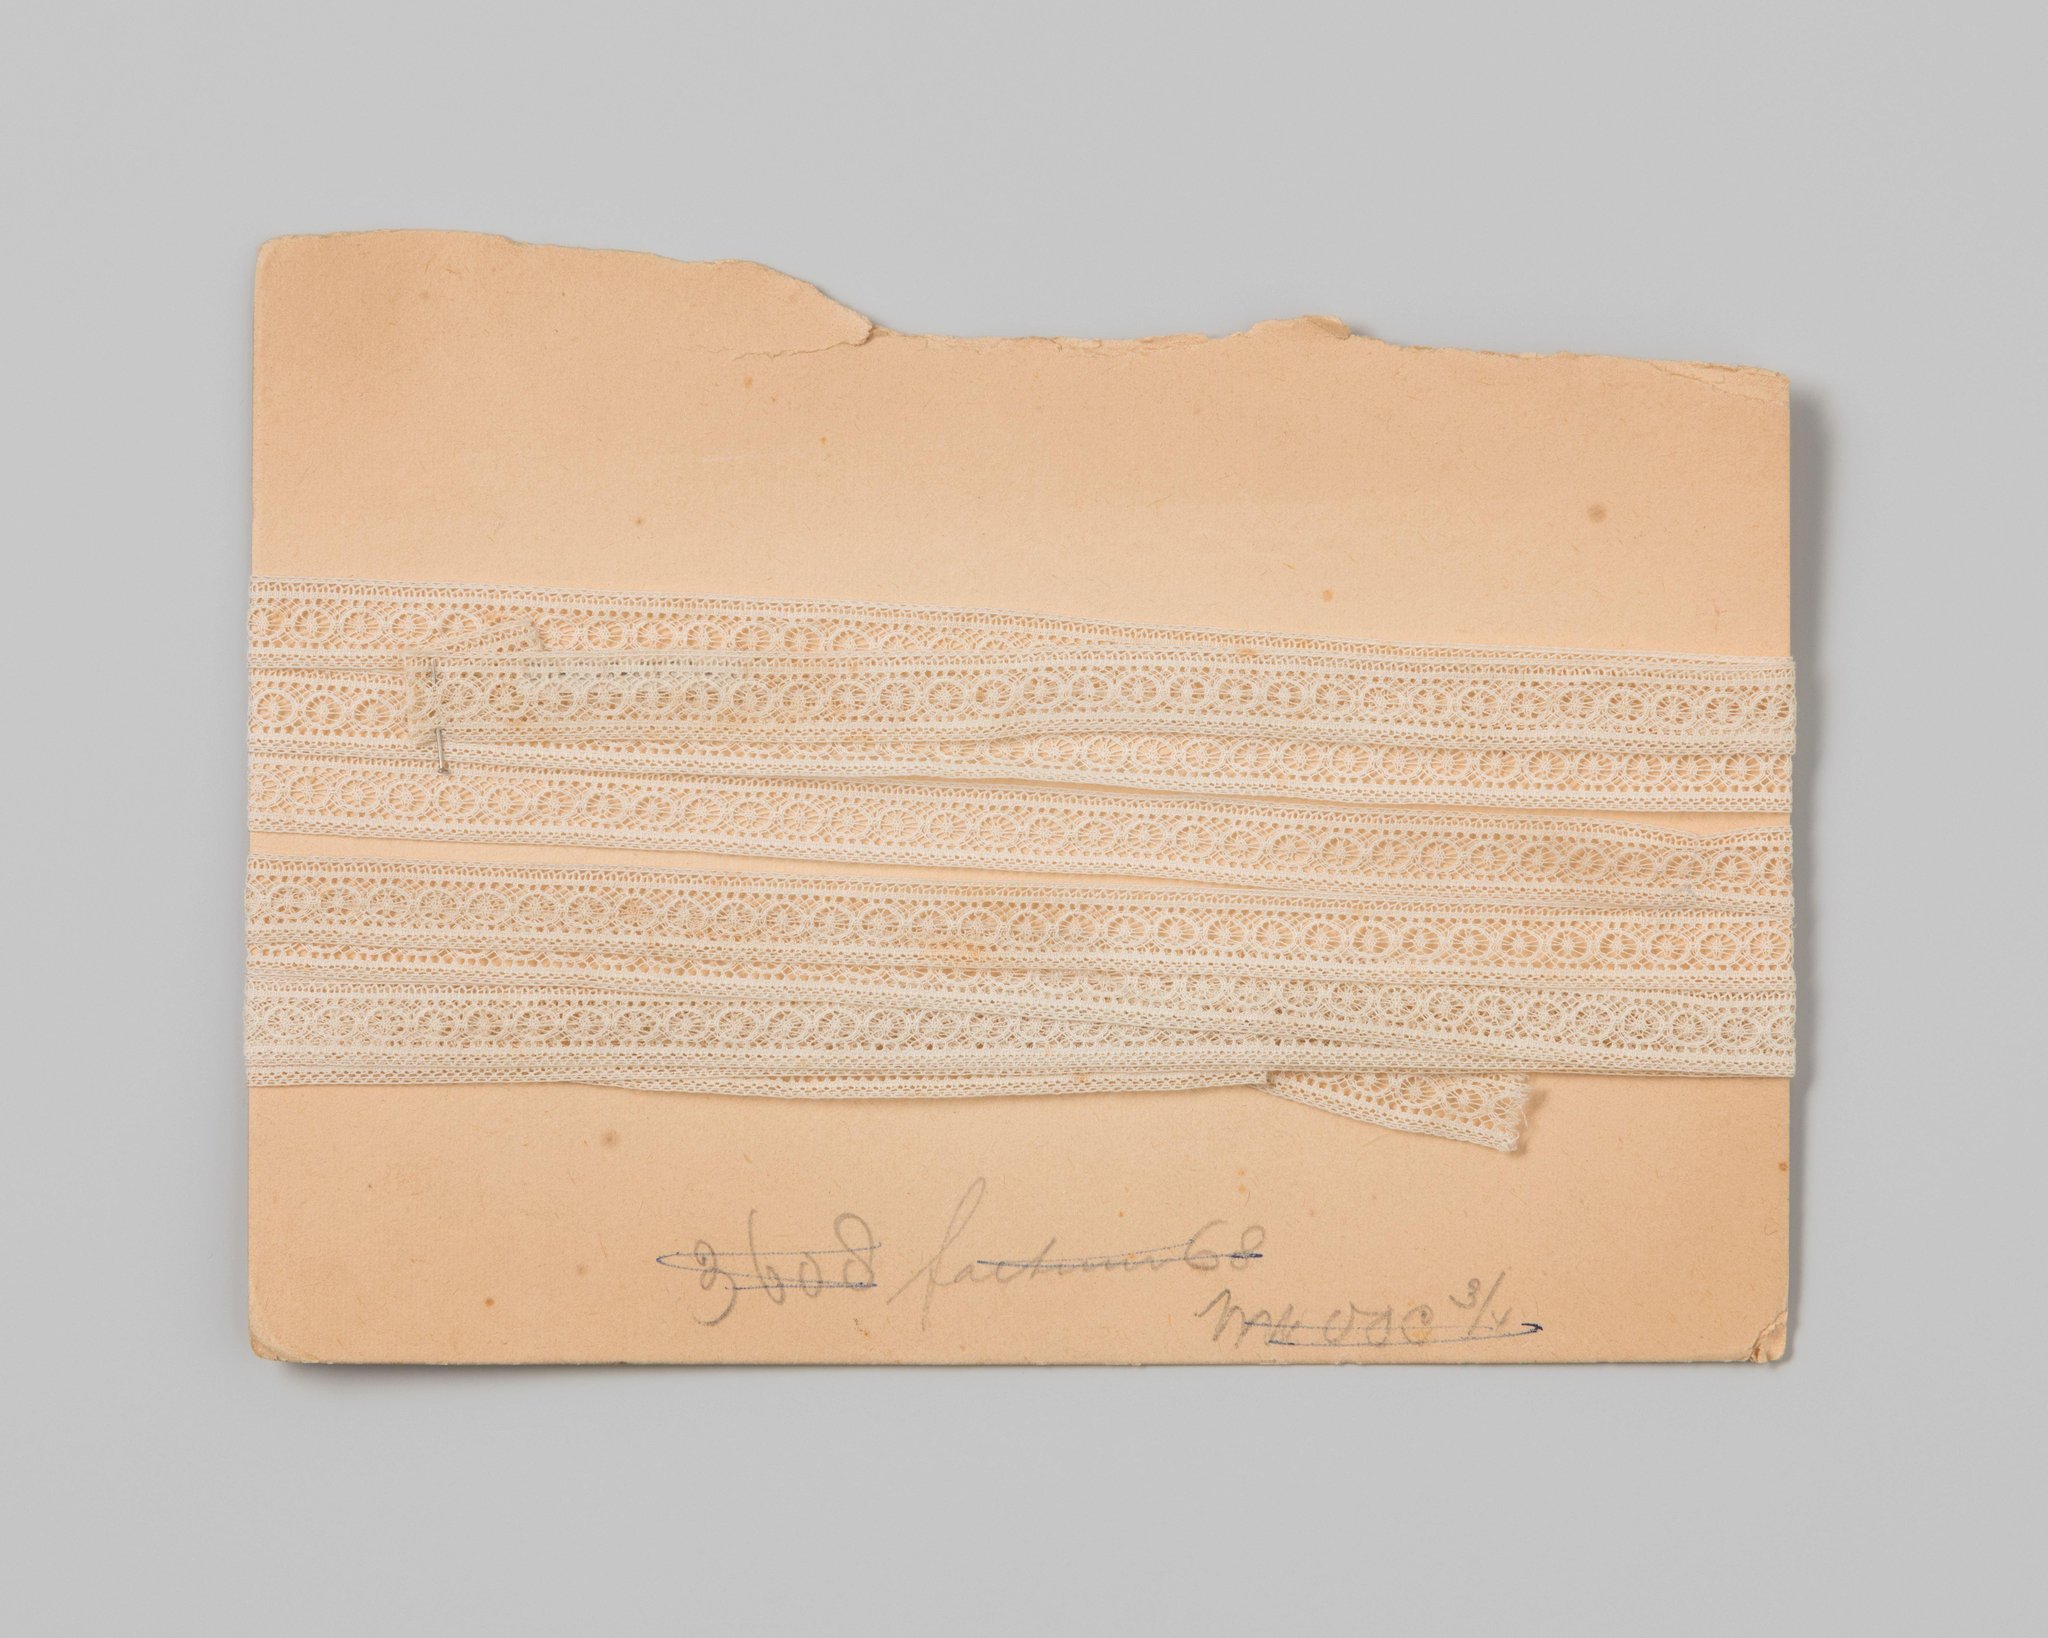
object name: ribbon material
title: Tussenzetsel van wit kant met aaneengeregen wielen op karton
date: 1920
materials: cardboard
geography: belgium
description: Tussenzetsel van wit kant met aaneengeregen wielen op karton.